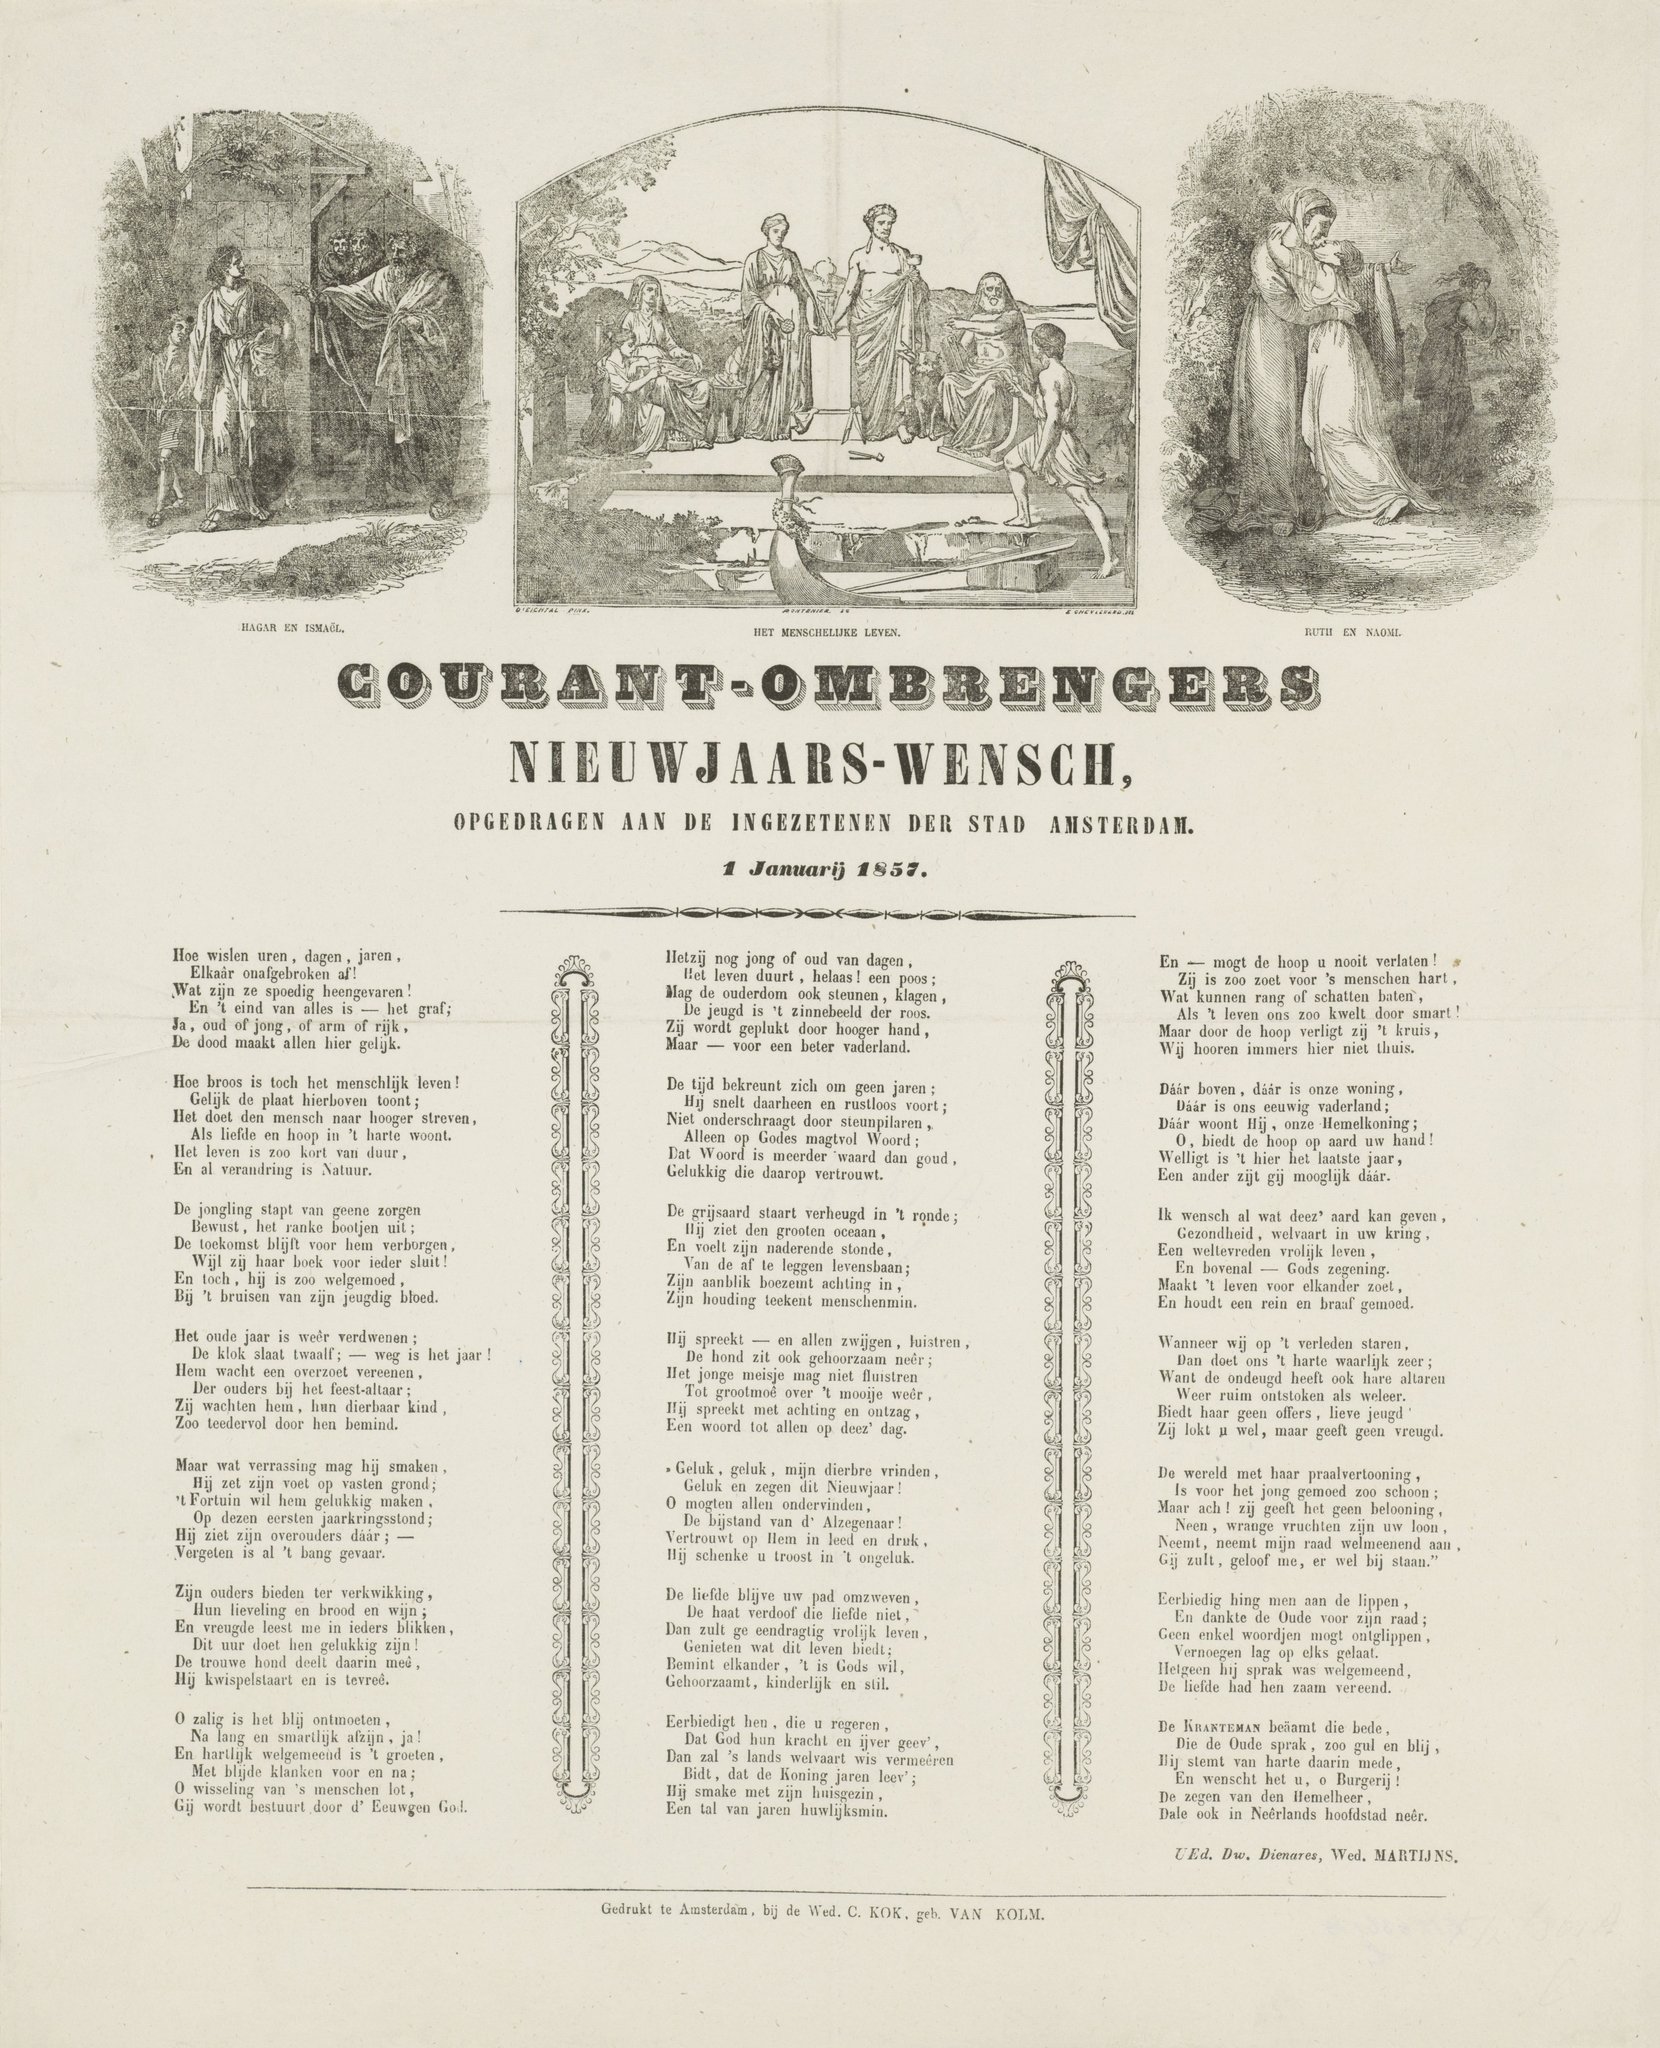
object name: new year card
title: Courant-ombrengers Nieuwjaars-Wensch (...) 1857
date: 1856-1857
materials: paper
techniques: letterpress printing, engraving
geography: amsterdam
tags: hagar and ishmael (often with bow and arrow) depart, the story of ruth, the moabitess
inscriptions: collector's mark: Lugt 2228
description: Nieuwjaarswens namens de ombrengers van couranten (krantenbezorgers) te Amsterdam voor het jaar 1857. Bovenaan drie vignetten aan boeken ontleend, met centraal een mythologische scène getiteld 'Het menschelijke leven', links de verstoting van Hagar en Ismaël, rechts Ruth en Naomi. Onderaan een gedicht in drie kolommen. Van de courantombrengster: wed. Martijns.